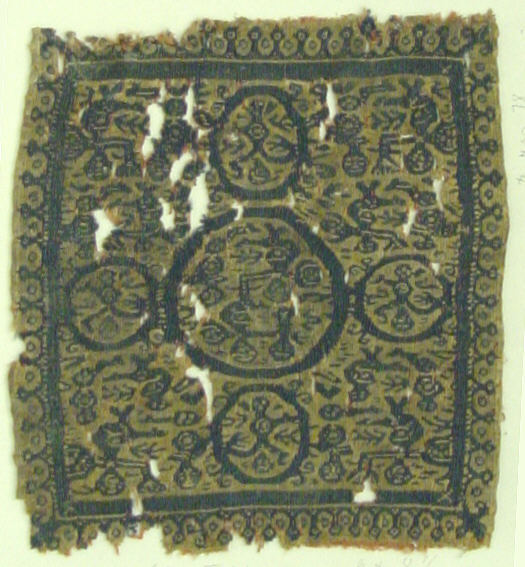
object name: textile fragment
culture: coptic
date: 601-700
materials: linen, wool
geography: egypt